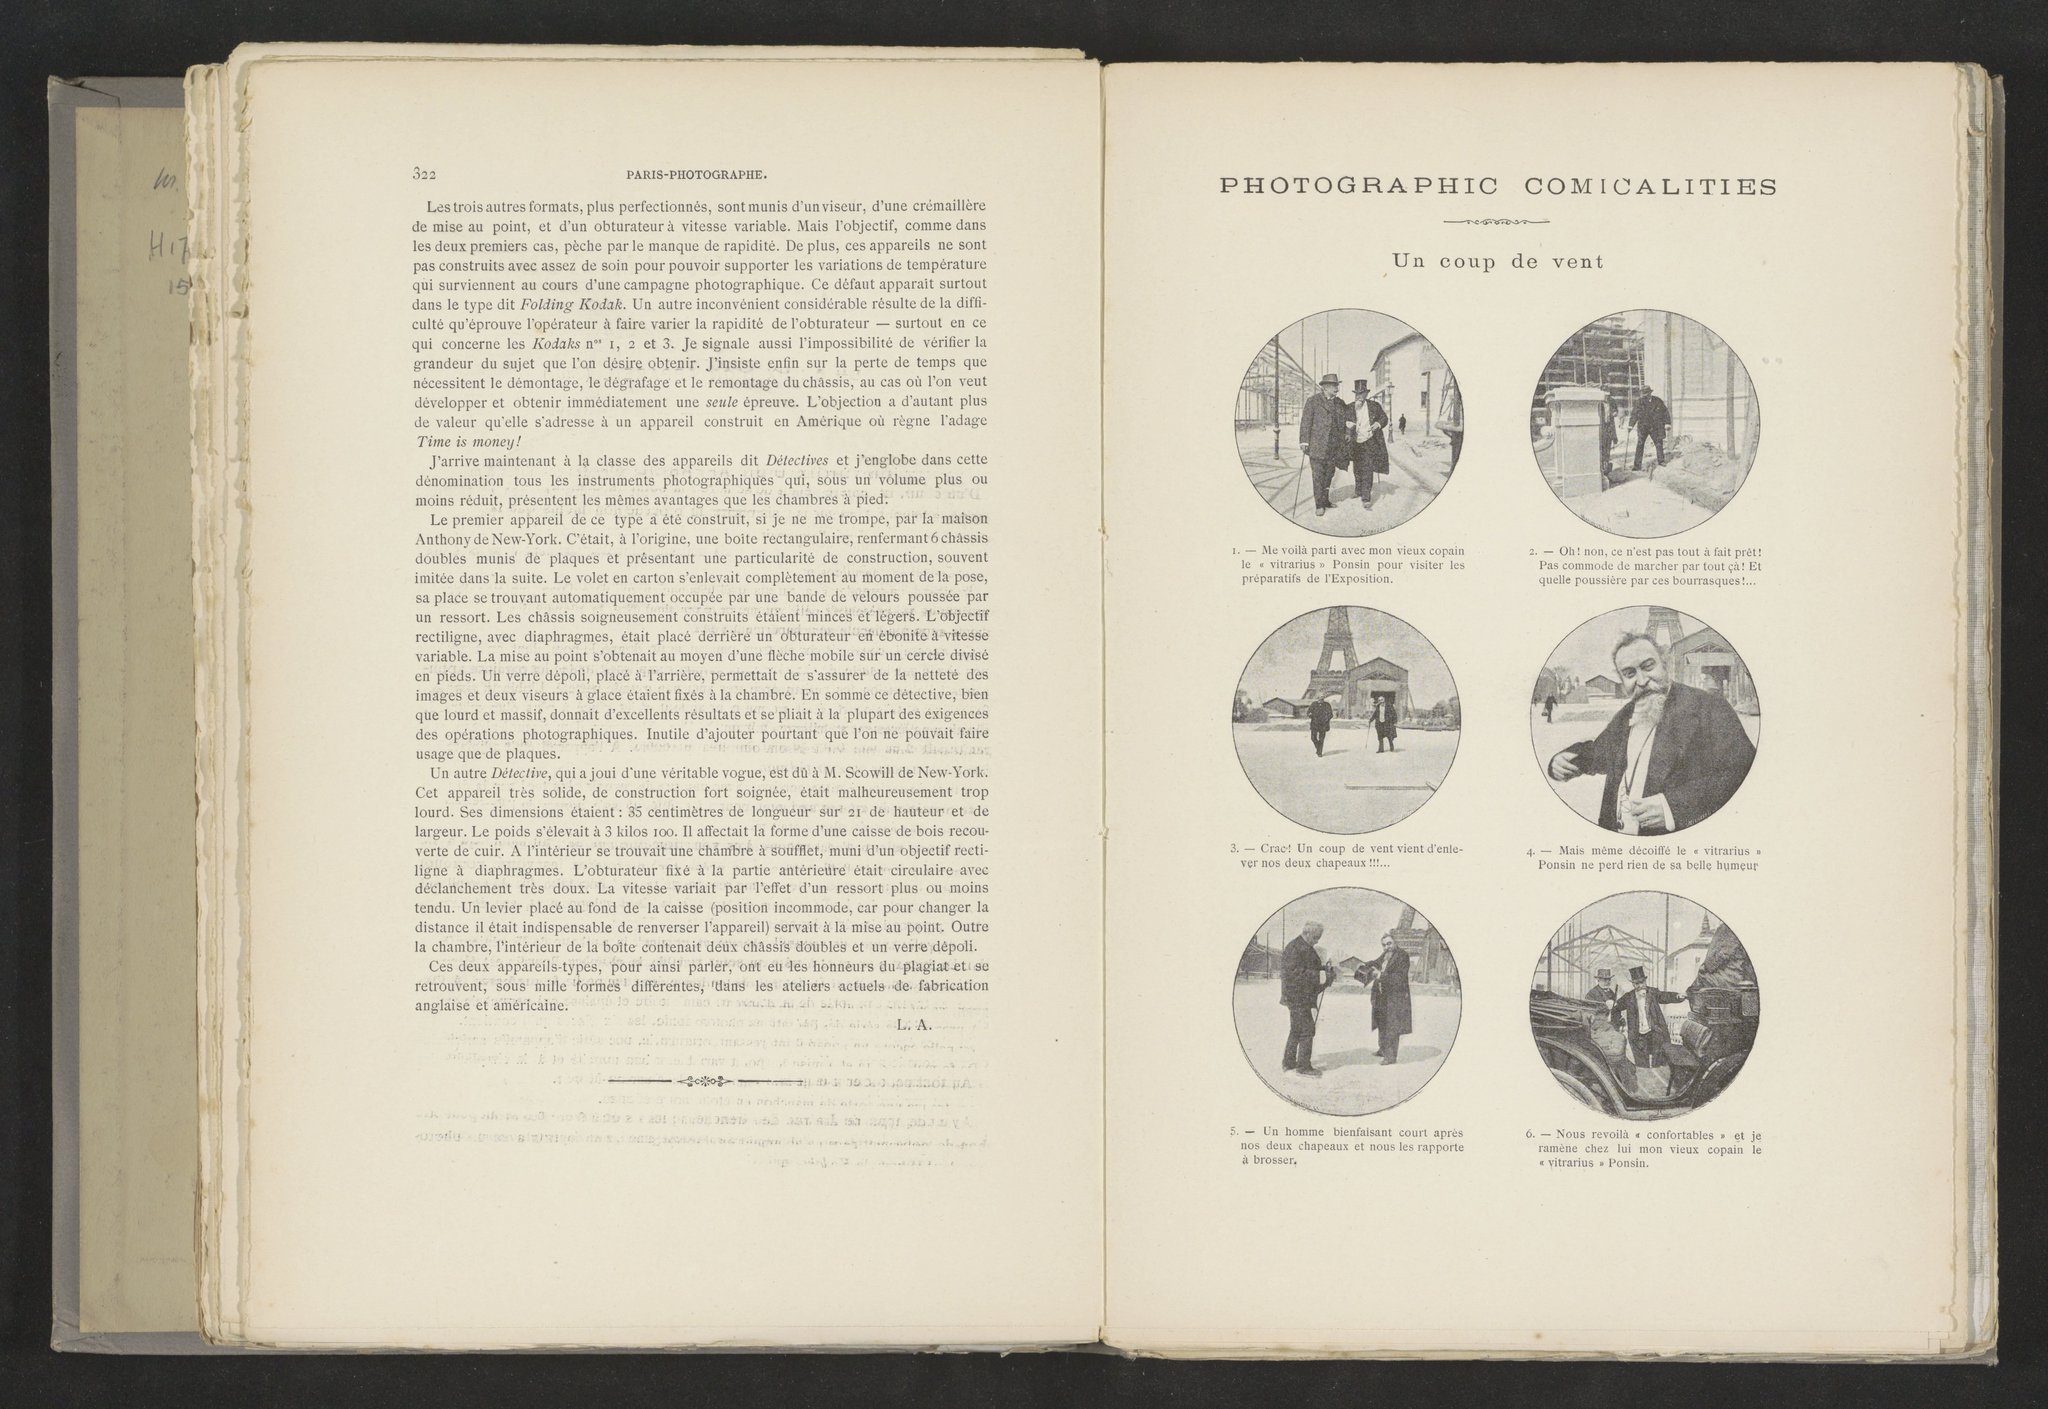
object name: photomechanical print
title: Un coup de vent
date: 1881-1891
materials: paper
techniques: autotype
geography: france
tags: storm, head-gear: top hat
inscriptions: inscription: ‘Me voilà (...) le 'vitrarius' Ponsin.’, number: ‘1. (...) 6.’, inscription: ‘Photographic comicalities’